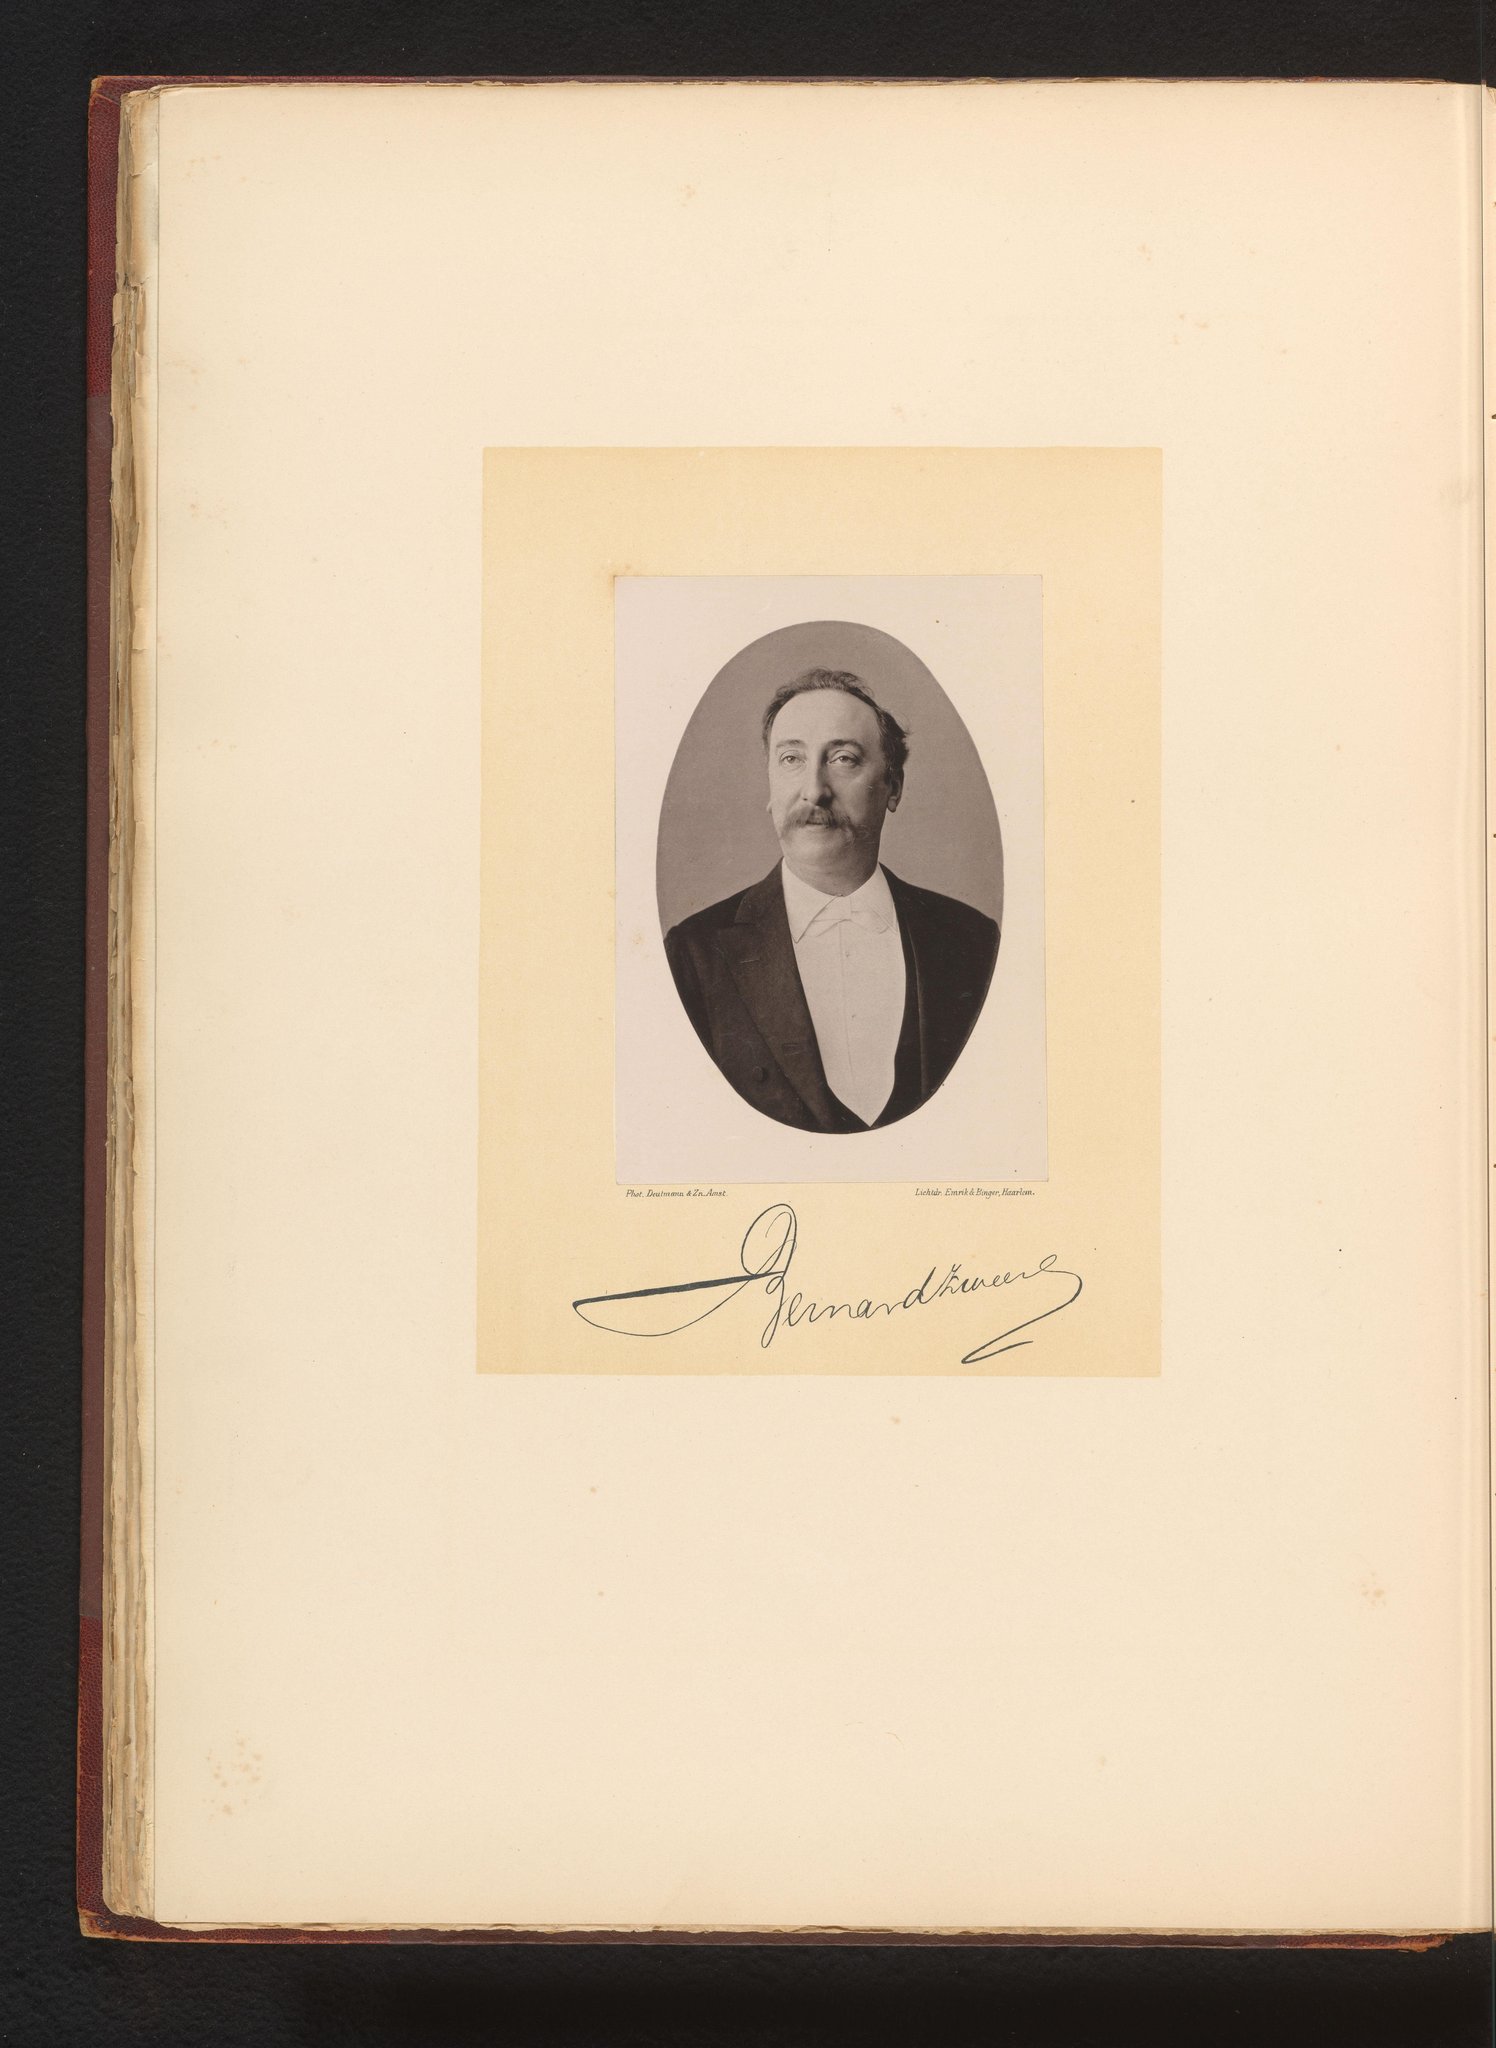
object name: page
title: Bernard Zweers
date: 1888-1896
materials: paper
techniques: photograph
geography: haarlem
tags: historical persons, portrait of composer